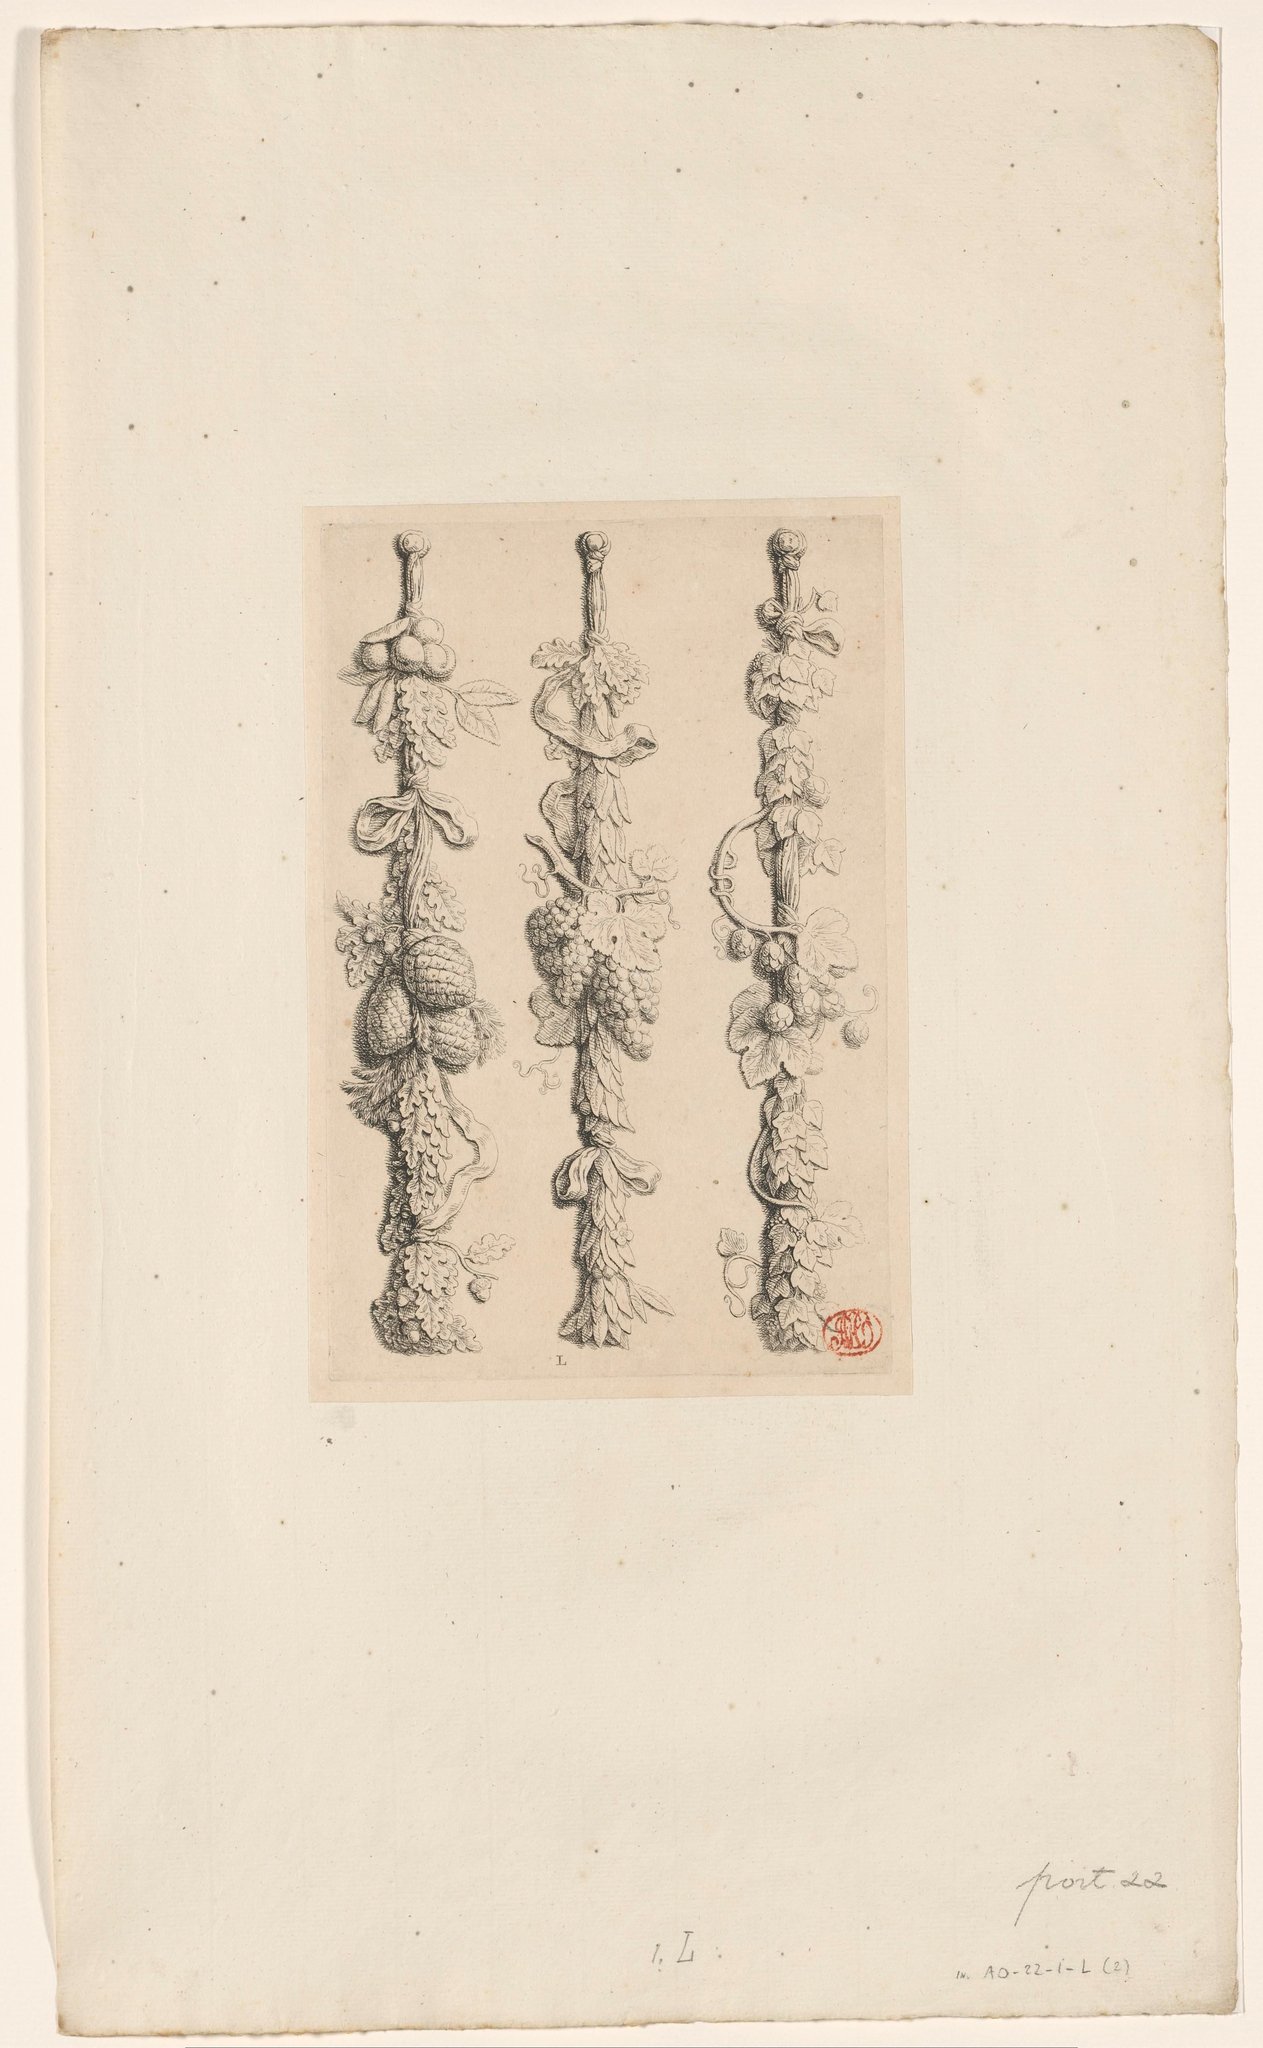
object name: print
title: Drie festoenen met druiven, dennenappels en bladeren in de zuidelijke galerij van het Stadhuis op de Dam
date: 1655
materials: paper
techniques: engraving, etching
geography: amsterdam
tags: fruits and vegetables ~ ornament, ornament ~ festoon, garland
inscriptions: collector's mark: Lugt 195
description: Prent gebruikt in: Prima pars. Praecipuarum effigierum ac ornamentorum, amplissimae Curiae Amstelrodamensis (…) / Het eerste deel. Van de voornaemste Statuen ende Ciraten, vant konstijck Stadhuys van Amstelredam, tmeeste in marmer gemaeckt, door Artus Quellinus, Beelthouwer der voorseyde Stadt / La Premier Partie. De plusieurs Figures et ornements, de la Maison de Ville d'Amsterdam (…). Amsterdam: Artus Quellinus (I), 1655. Zie RP-P-AO-22-1-1 voor bijhorende titelpagina. Zie RP-P-AO-22-1-2 voor bijhorend register. Zie RP-P-AO-22-1A, RP-P-AO-22-1B, RP-P-AO-22-1C, RP-P-AO-22-1D-1, RP-P-AO-22-1D-2, RP-P-AO-22-1E, RP-P-AO-22-1F, RP-P-AO-22-1G, RP-P-AO-22-1H, RP-P-AO-22-1I, RP-P-AO-22-1K-1, RP-P-AO-22-1K-2, RP-P-AO-22-1K-3, RP-P-AO-22-1K-4, RP-P-AO-22-1K-5, RP-P-AO-22-1L-1, RP-P-AO-22-1M-1, RP-P-AO-22-1M-2, RP-P-AO-22-1N-1, RP-P-AO-22-1N-2, RP-P-AO-22-1N-3, RP-P-AO-22-1N-4, RP-P-AO-22-1N-5, RP-P-AO-22-1O-1, RP-P-AO-22-1O-2, RP-P-AO-22-1O-3, RP-P-AO-22-1O-4, RP-P-AO-22-1P-1, RP-P-AO-22-1P-2, RP-P-AO-22-1P-3, RP-P-AO-22-1P-4, RP-P-AO-22-1Q-1, RP-P-AO-22-1Q-2, RP-P-AO-22-1Q-3, RP-P-AO-22-1Q-4, RP-P-AO-22-1R-1, RP-P-AO-22-1R-2, RP-P-AO-22-1R-3, RP-P-AO-22-1R-4, RP-P-AO-22-1R-5, RP-P-AO-22-1S-1, RP-P-AO-22-1S-2, RP-P-AO-22-1S-3, RP-P-AO-22-1S-4, RP-P-AO-22-1S-5, RP-P-AO-22-1T-1 en RP-P-AO-22-1T-2 voor andere prenten uit deze publicatie. Zelfde staat van prent ook gebruikt in: Prima pars. Praecipuarum effigierum ac ornamentorum, amplissimae Curiae Amstelrodamensis (…) / Het eerste deel. Van de voornaemste Statuen ende Ciraten, vant konstijck Stadhuys van Amstelredam, tmeeste in marmer gemaeckt, door Artus Quellinus, Beelthouwer der voorseyde Stadt / La Premier Partie. De plusieurs Figures et ornements, de la Maison de Ville d'Amsterdam (…). Amsterdam: Frederik de Wit, 1665. Latere staat van prent ook gebruikt in: Architecture peinture et sculpture de la Maison de Ville d'Amsterdam, representee en CIX. figures en taille-douce (…). Amsterdam: David Mortier, 1719. En in: Architecture peinture et sculpture de la Maison de Ville d'Amsterdam, representee en CIX. figures en taille-douce (…). Amsterdam: Gerard Valck, 1719. En in: Bouw schilder en beeldhouwkonst, van het Stadhuis te Amsteldam, vertoont in CIX figuuren (…). Amsterdam: Covens & Mortier & Covens Jr., s.a. (1774-1783).